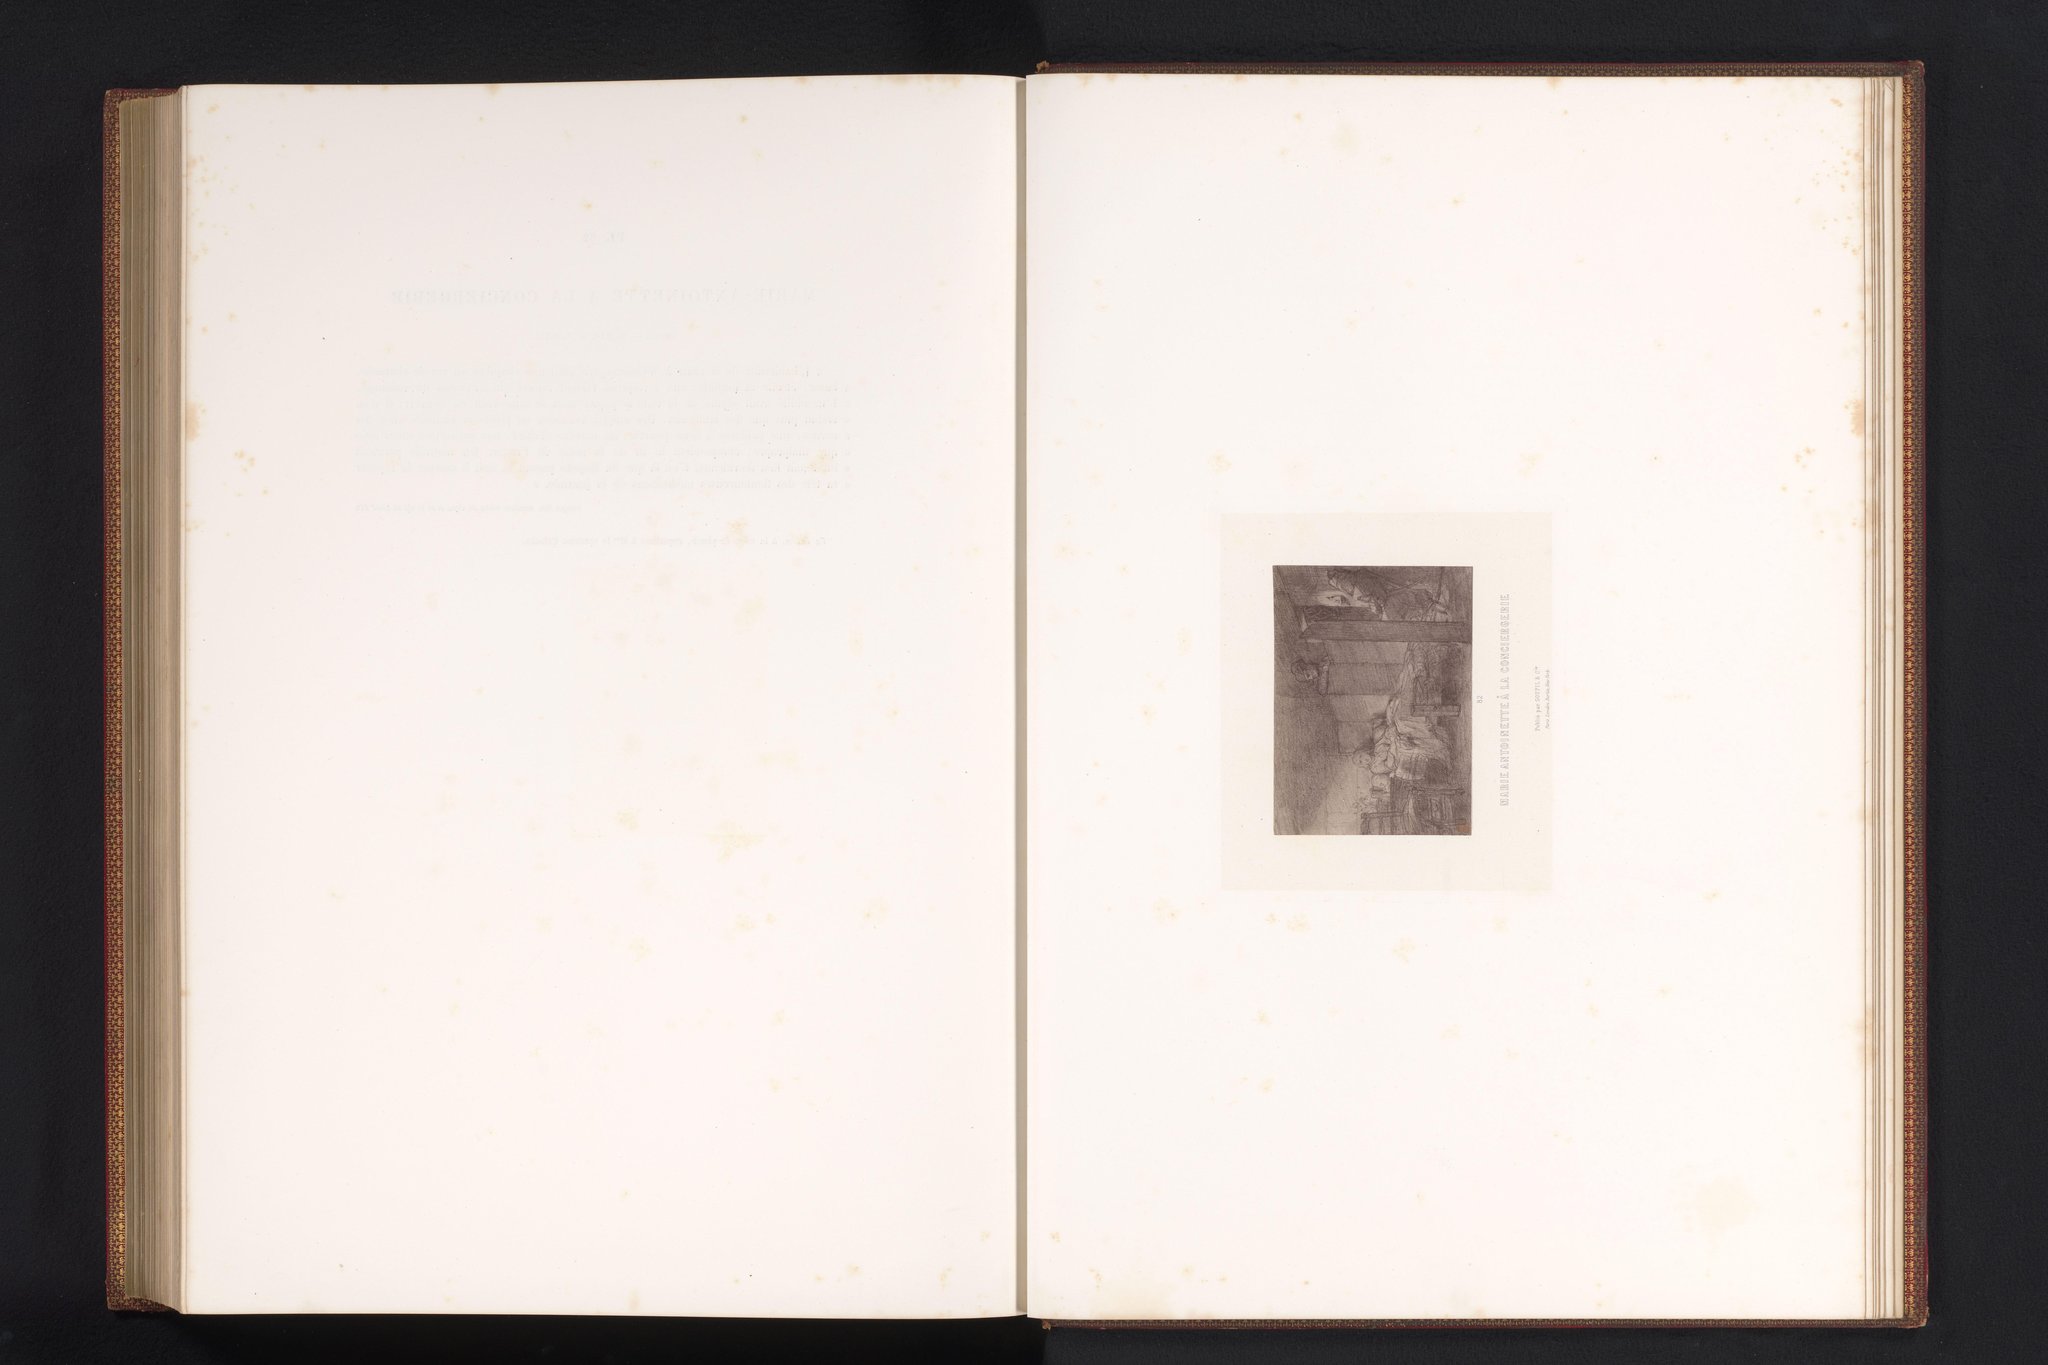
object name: page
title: Fotoreproductie van een tekening van Marie Antoinette in de cel door Paul Delaroche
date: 1853-1858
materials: paper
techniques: albumen print, engraving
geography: paris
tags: marie antoinette, queen, empress, etc. (wife of a ruler), prisoner in cell or locked place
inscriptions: initials: ‘GC’